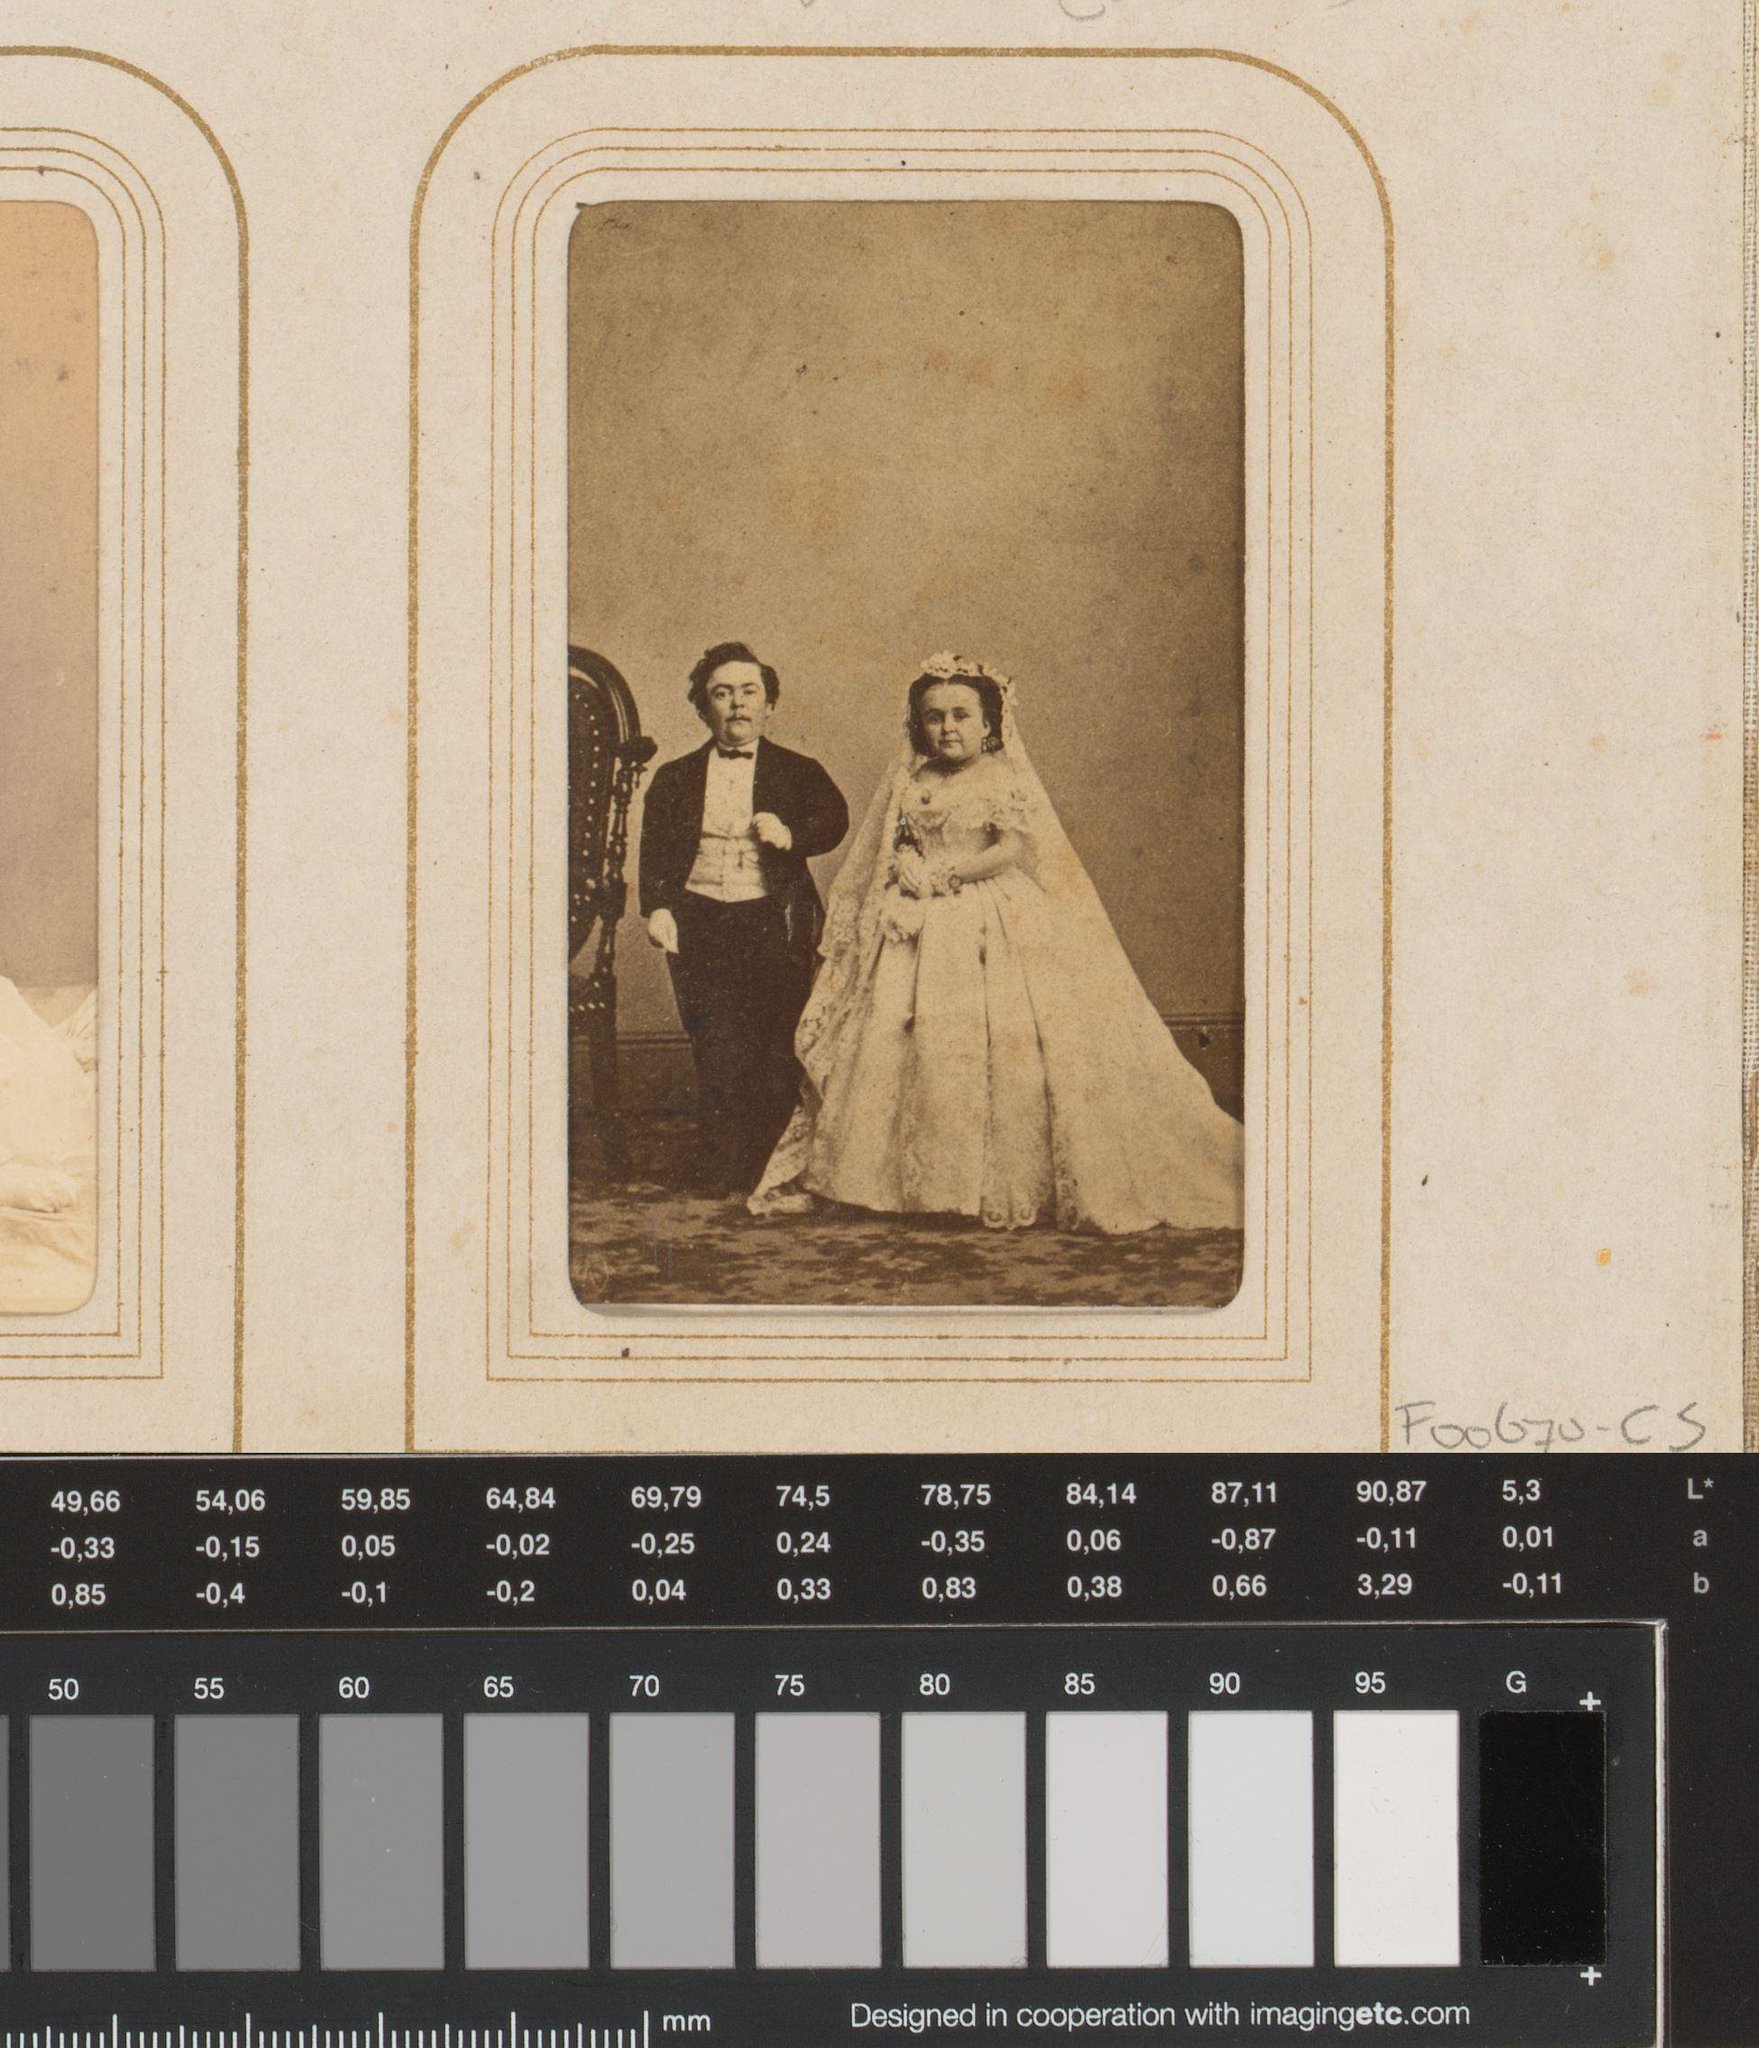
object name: album leaf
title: Portret van Tom Thumb en Lavinia Warren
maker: mathew benjamin brady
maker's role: fotograaf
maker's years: 1823-1896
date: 1864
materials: cardboard, photographic support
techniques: albumen print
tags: bride and groom in wedding-dress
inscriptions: number: ‘70’, name: ‘Thom Thumb + Lavinia Warren’